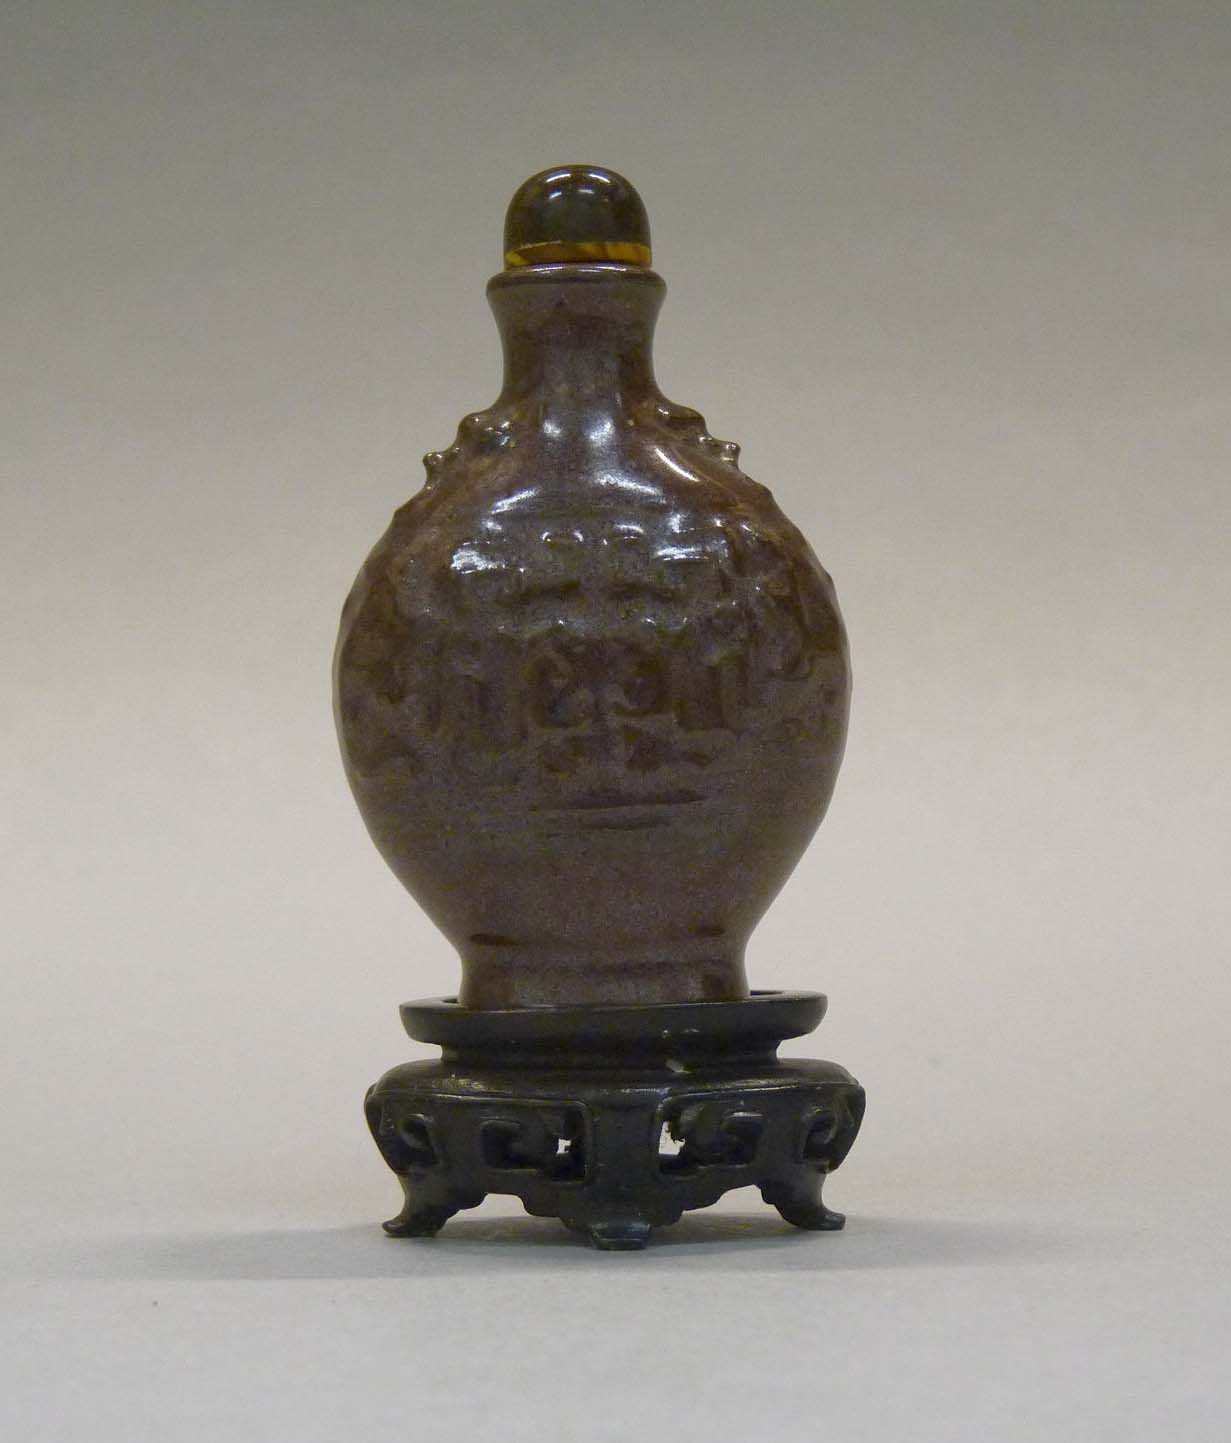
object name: snuff bottle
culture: chinese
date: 1736-1795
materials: amber, glass, porcelain